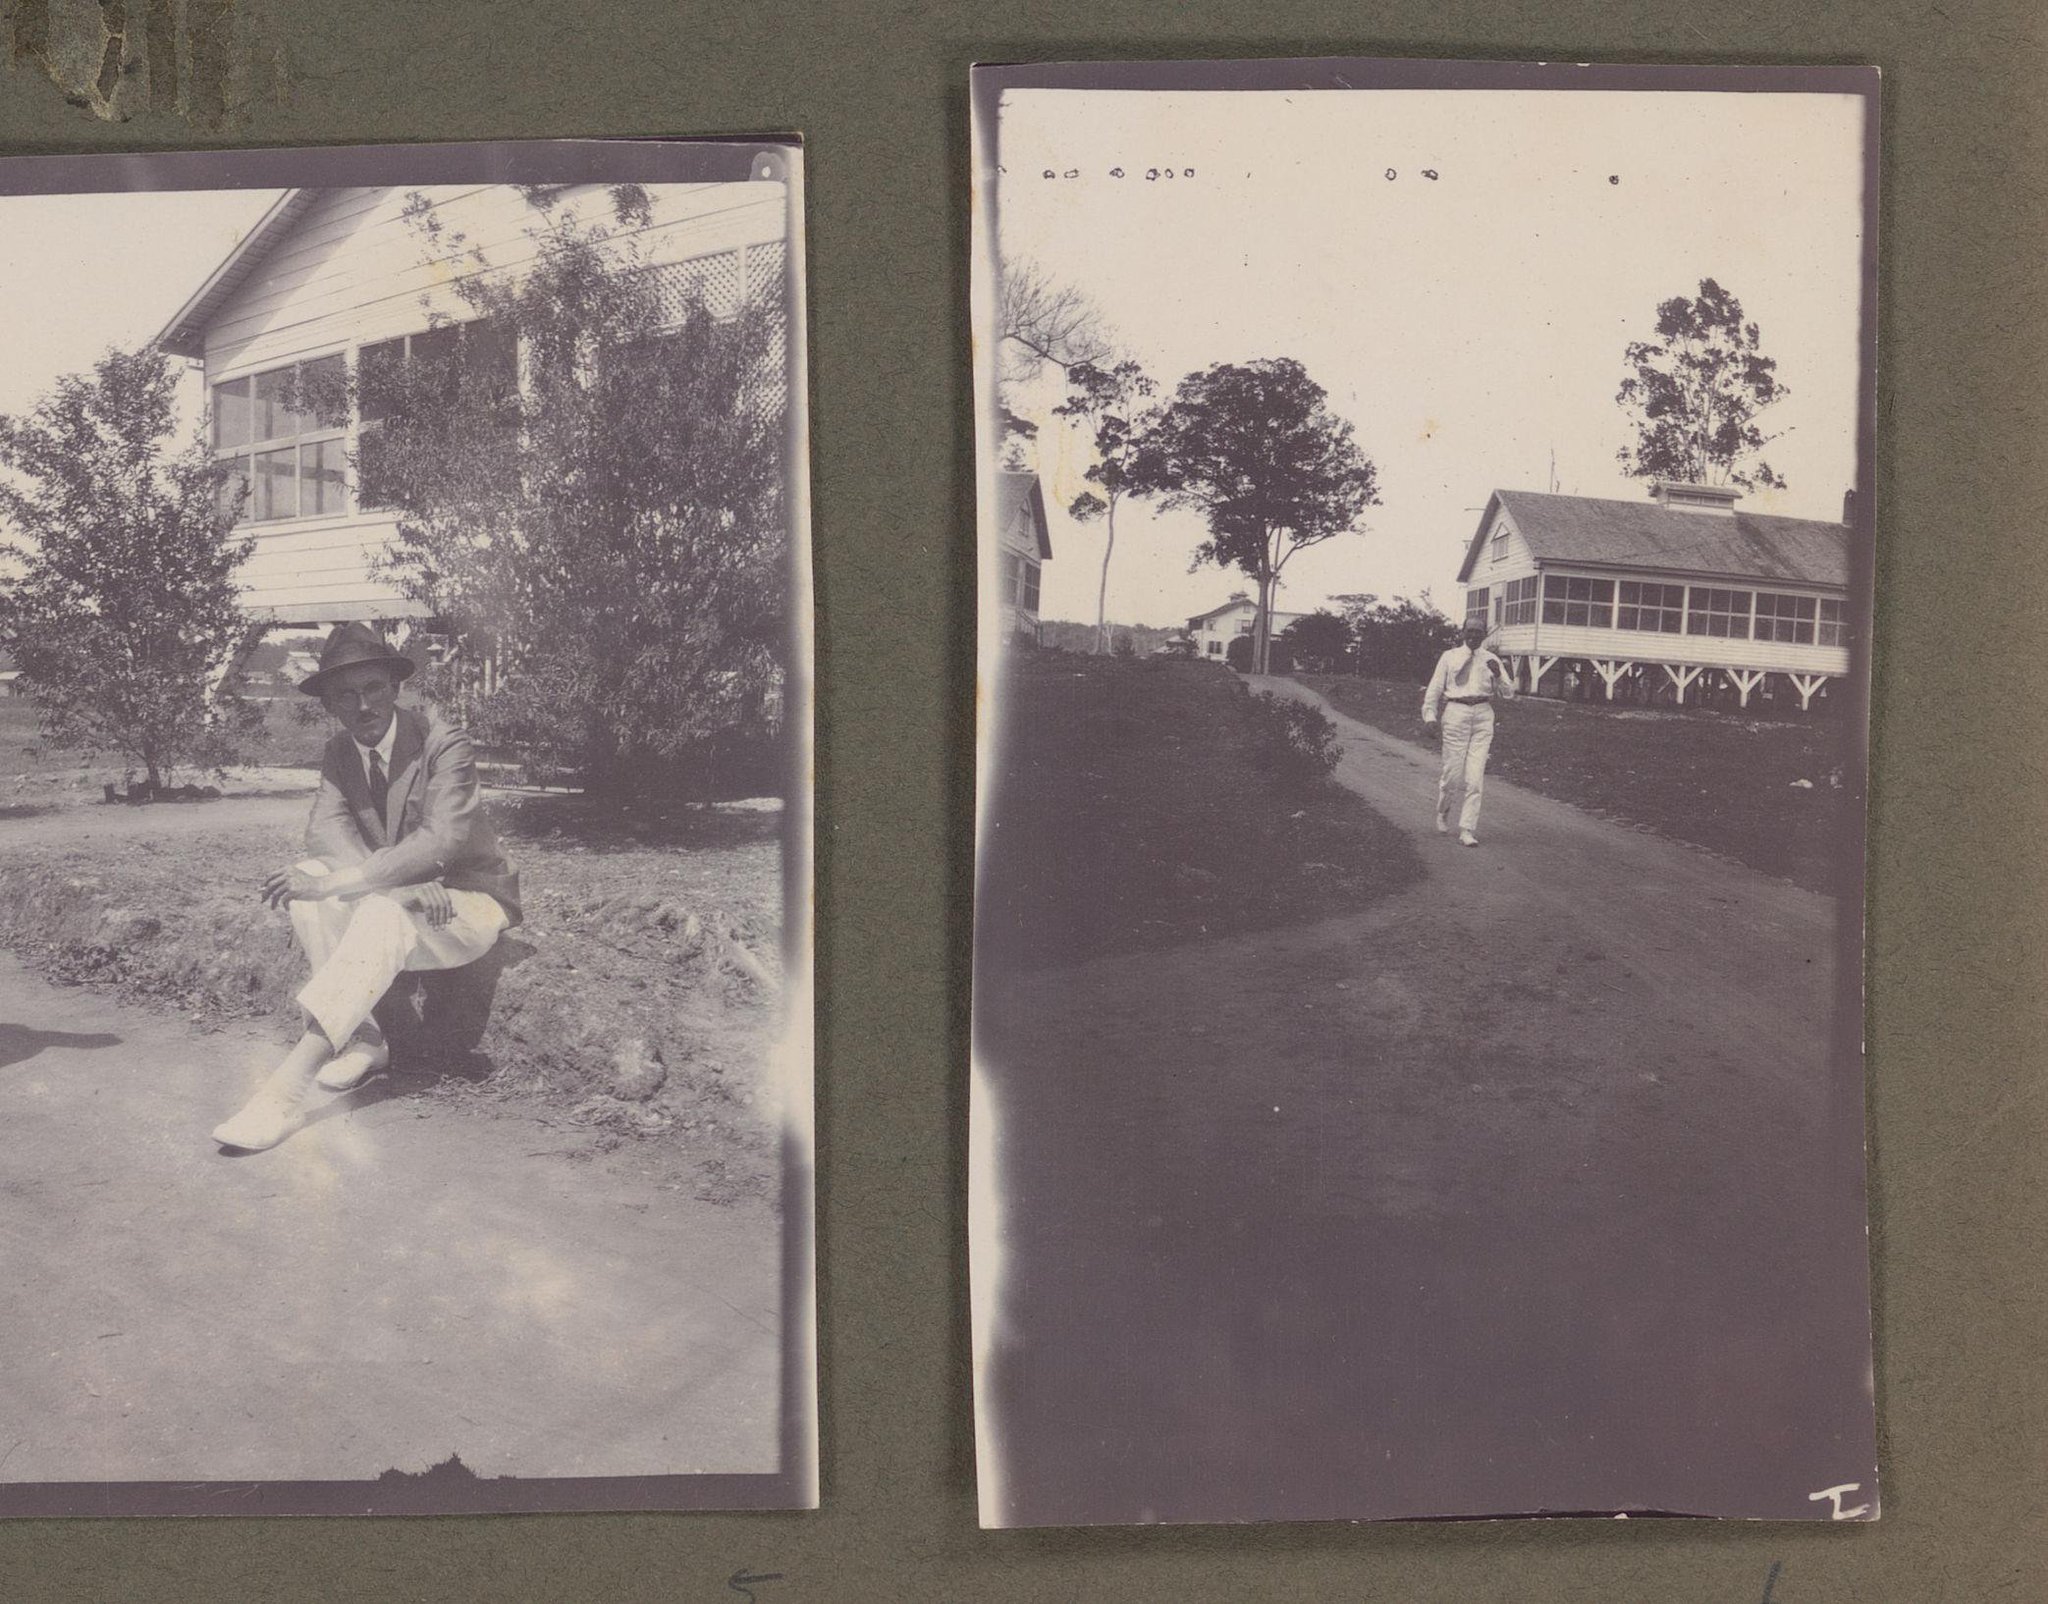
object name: photograph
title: Familiefoto te Moengo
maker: Anonymous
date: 1925-1927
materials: photographic support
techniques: photography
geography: suriname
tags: jetten, familie, moengo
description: Familiefoto met een lopende man te Moengo. Foto op een bladzijde van een los albumblad. Onderdeel van het ensemble met foto's van de familie van ingenieur Jetten in de mijnbouwstad Moengo in Suriname.